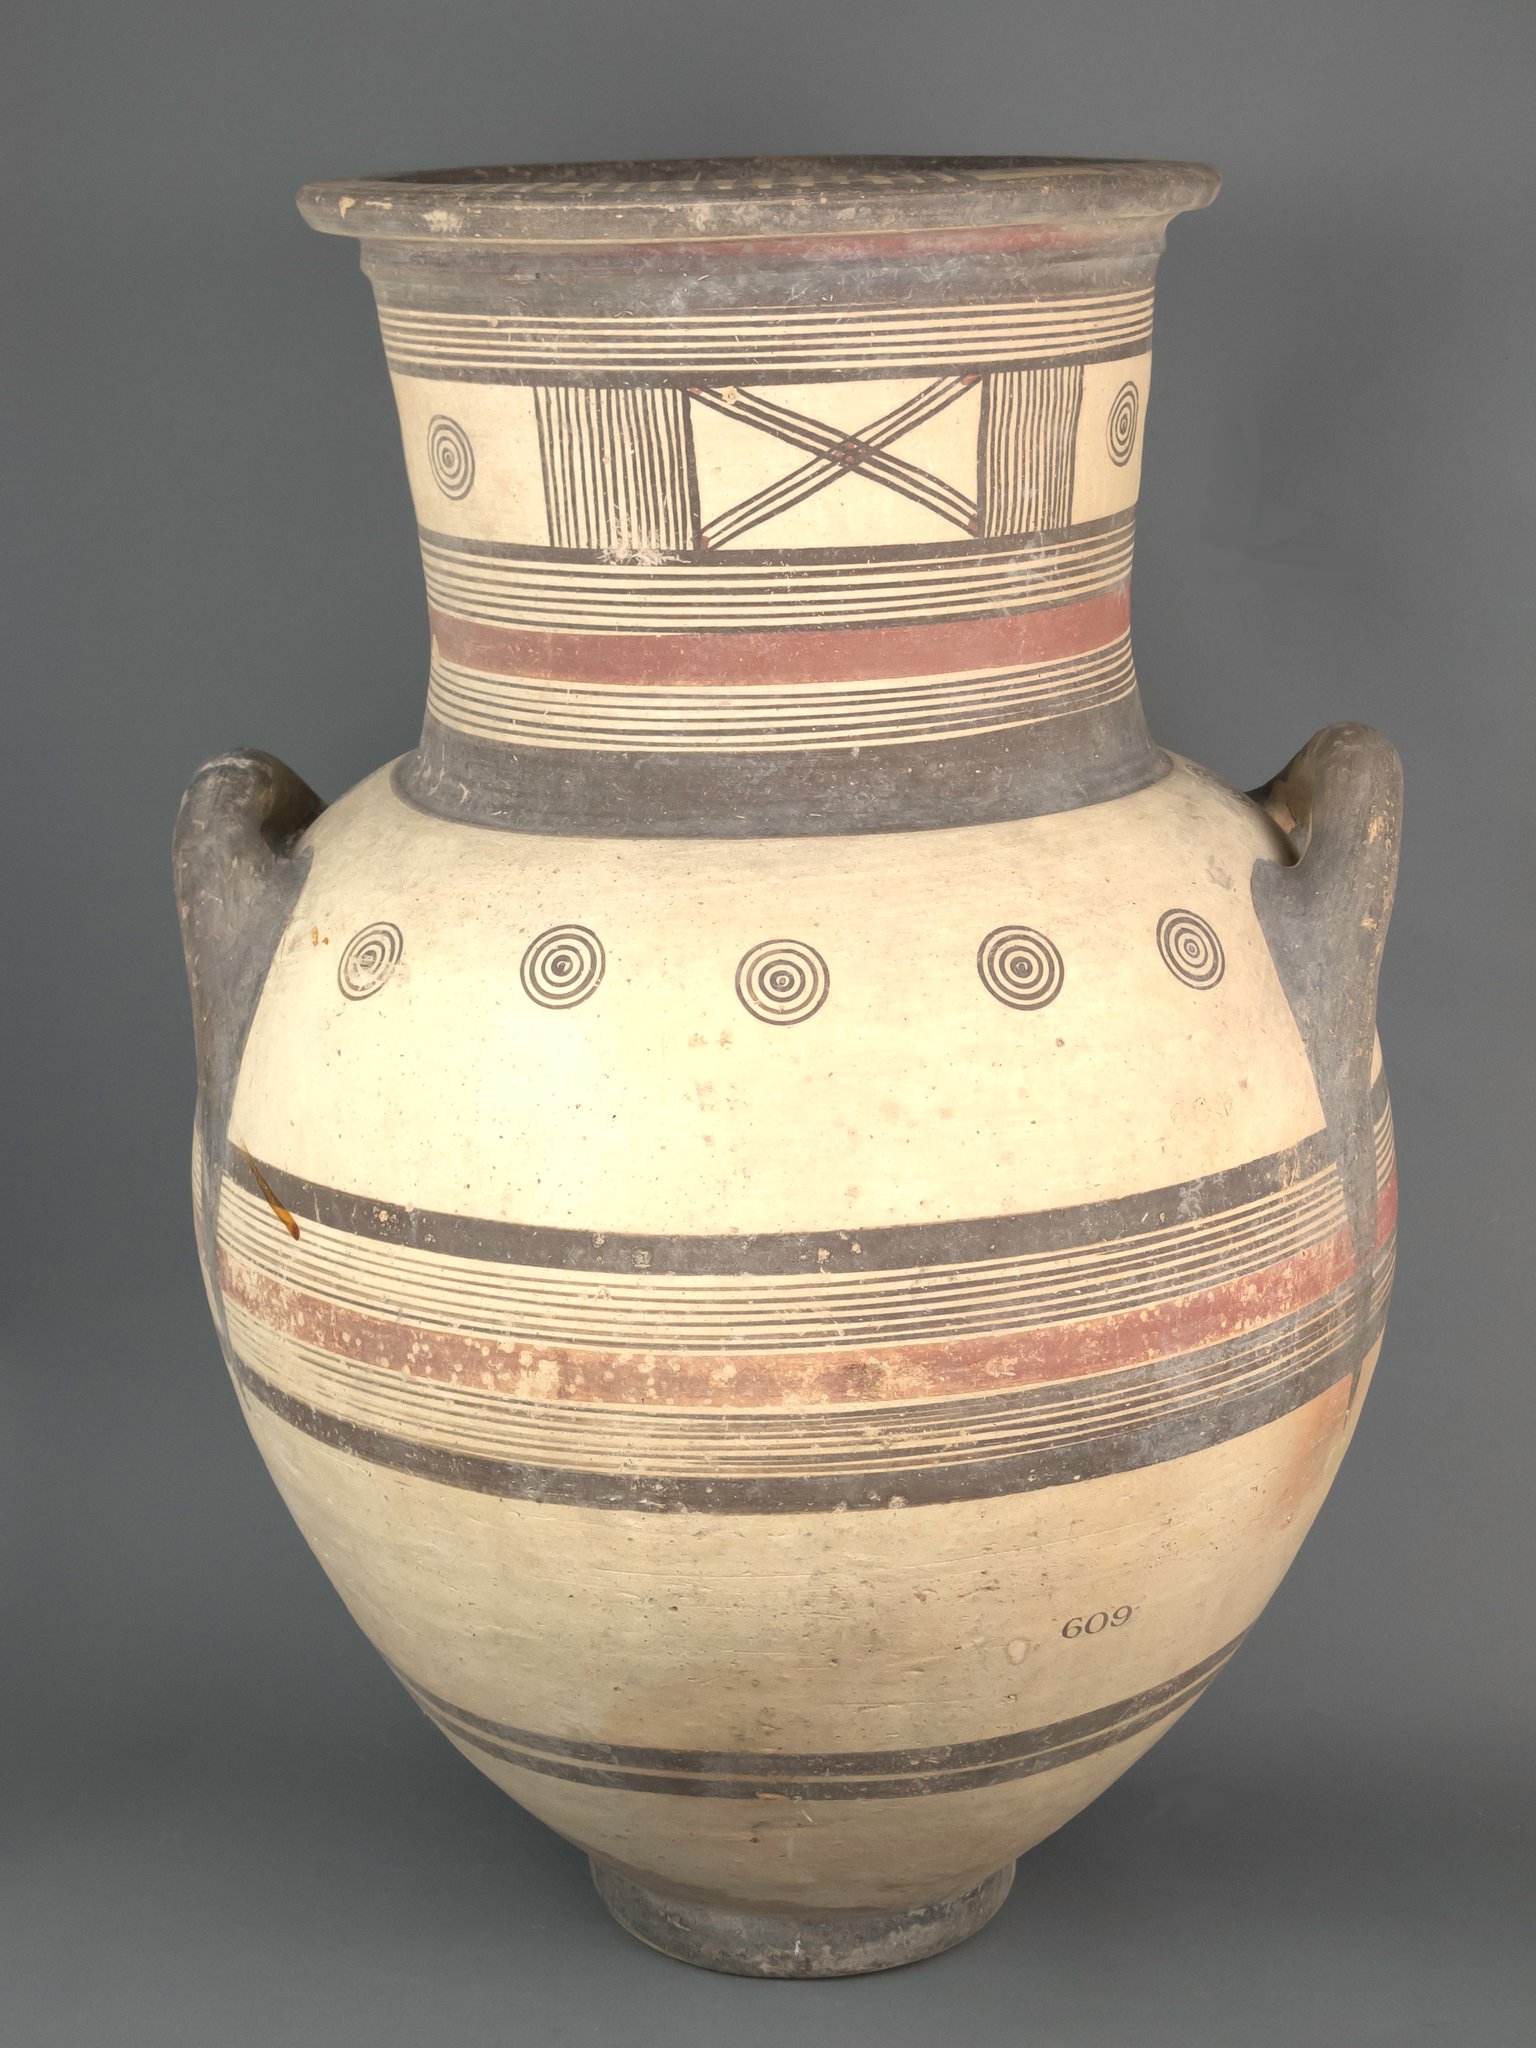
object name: amphora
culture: cypriot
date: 1050-900 BCE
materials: terracotta